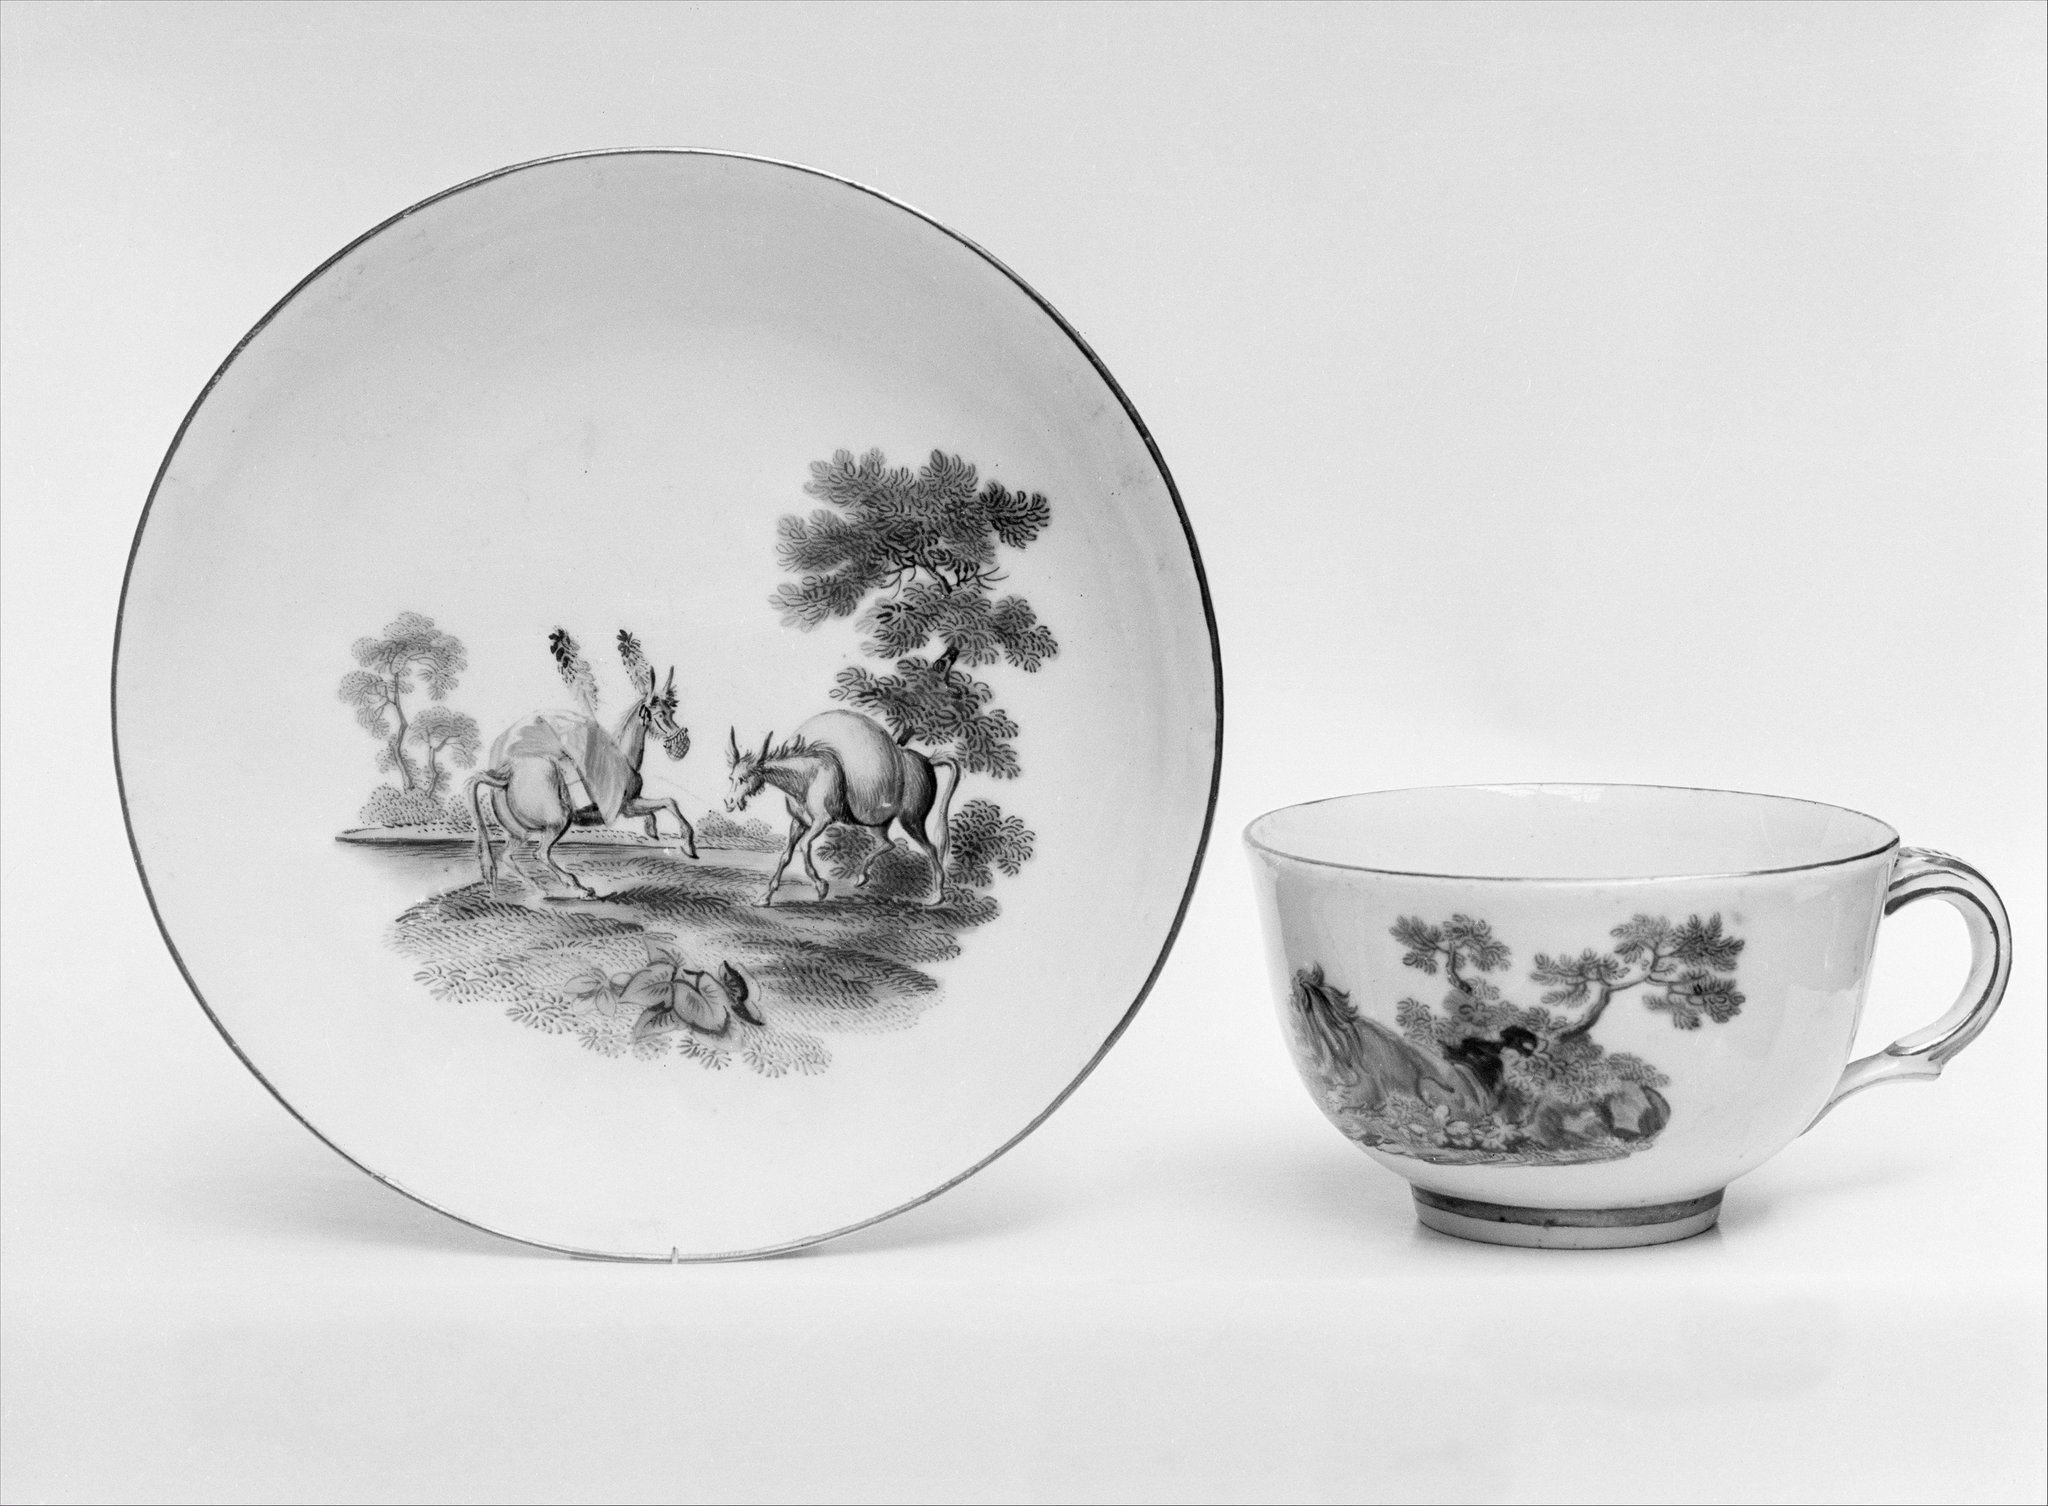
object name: cup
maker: tournai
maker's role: factory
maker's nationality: belgian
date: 1763-1771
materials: soft paste porcelain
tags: lions,trees